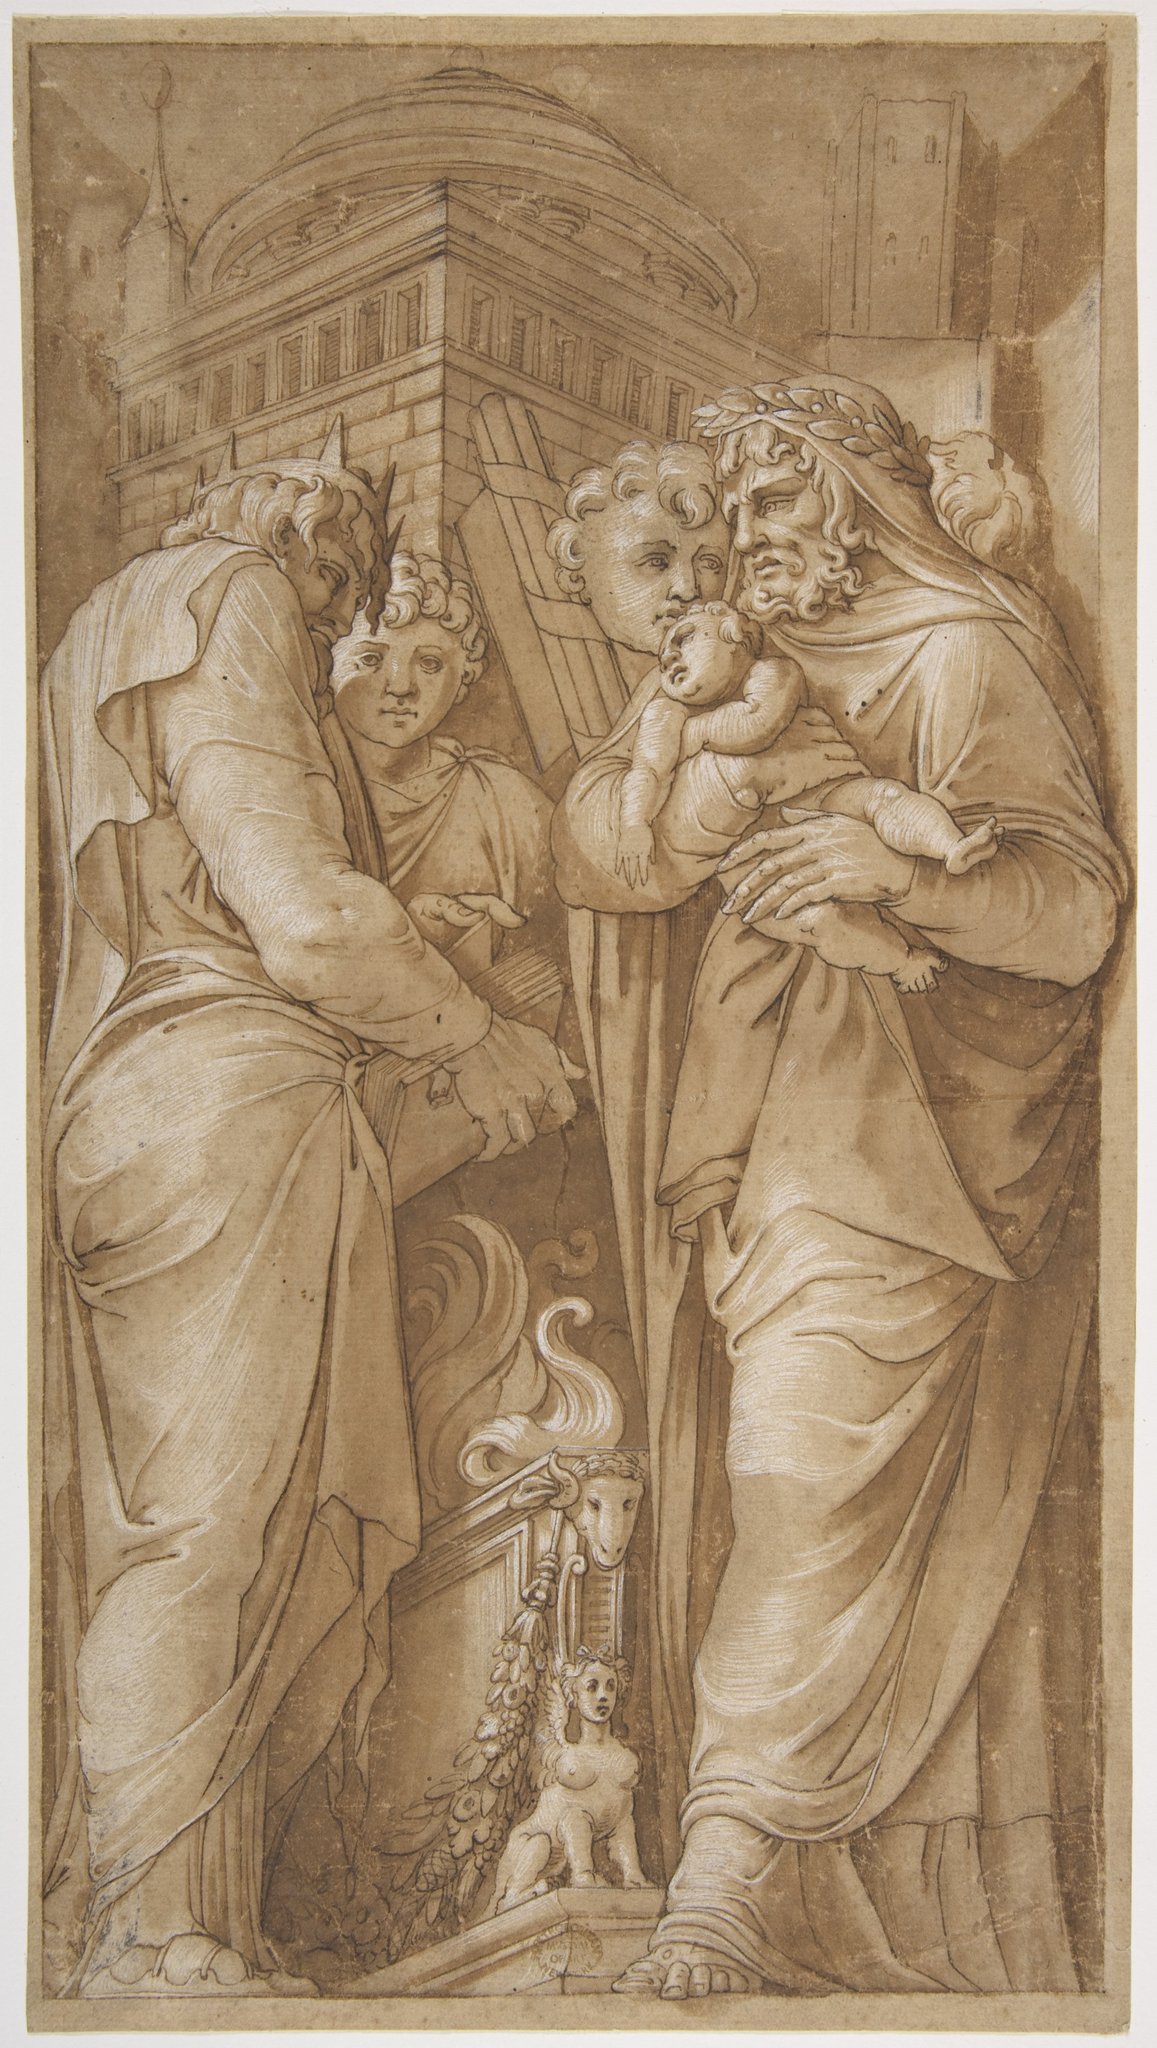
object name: drawing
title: Roman Scene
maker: polidoro da caravaggio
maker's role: artist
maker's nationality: italian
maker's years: 1494-1548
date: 1499-1543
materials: ink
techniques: brush, highlighting, pen, wash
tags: infants,men